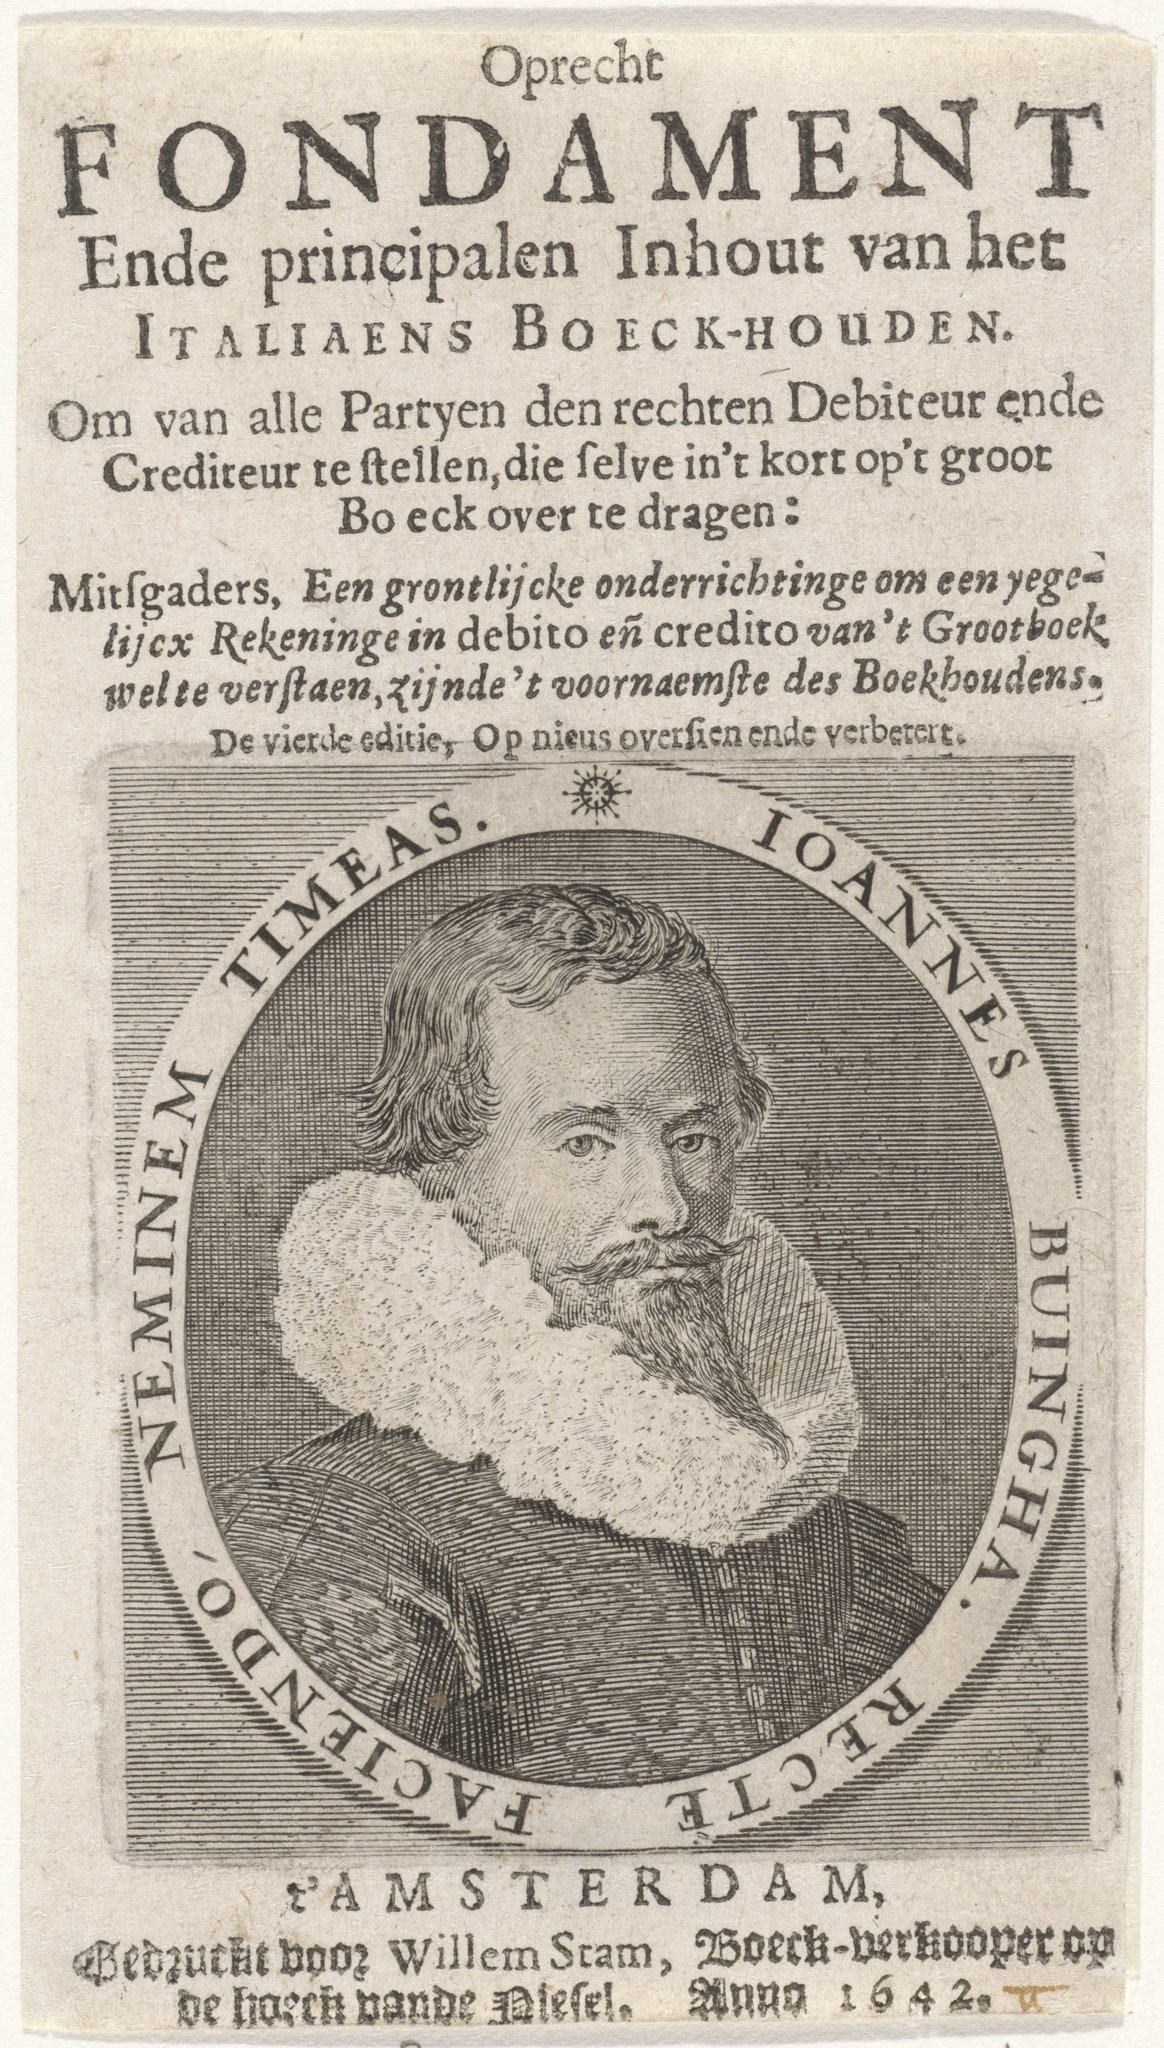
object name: print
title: Titelpagina voor: J. Buingha, Oprecht fondament ende principalen inhout van het Italiaens boeck-houden, 1642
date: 1642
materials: paper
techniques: engraving, etching, letterpress printing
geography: amsterdam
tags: boekhouder, joannes buingha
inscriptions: collector's mark: Lugt 2228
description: Titelpagina voor: Buingha, Joannes. Oprecht fondament ende principalen inhout van het Italiaens boeck-houden. Amsterdam: Willem Willemsz Stam, 1642.